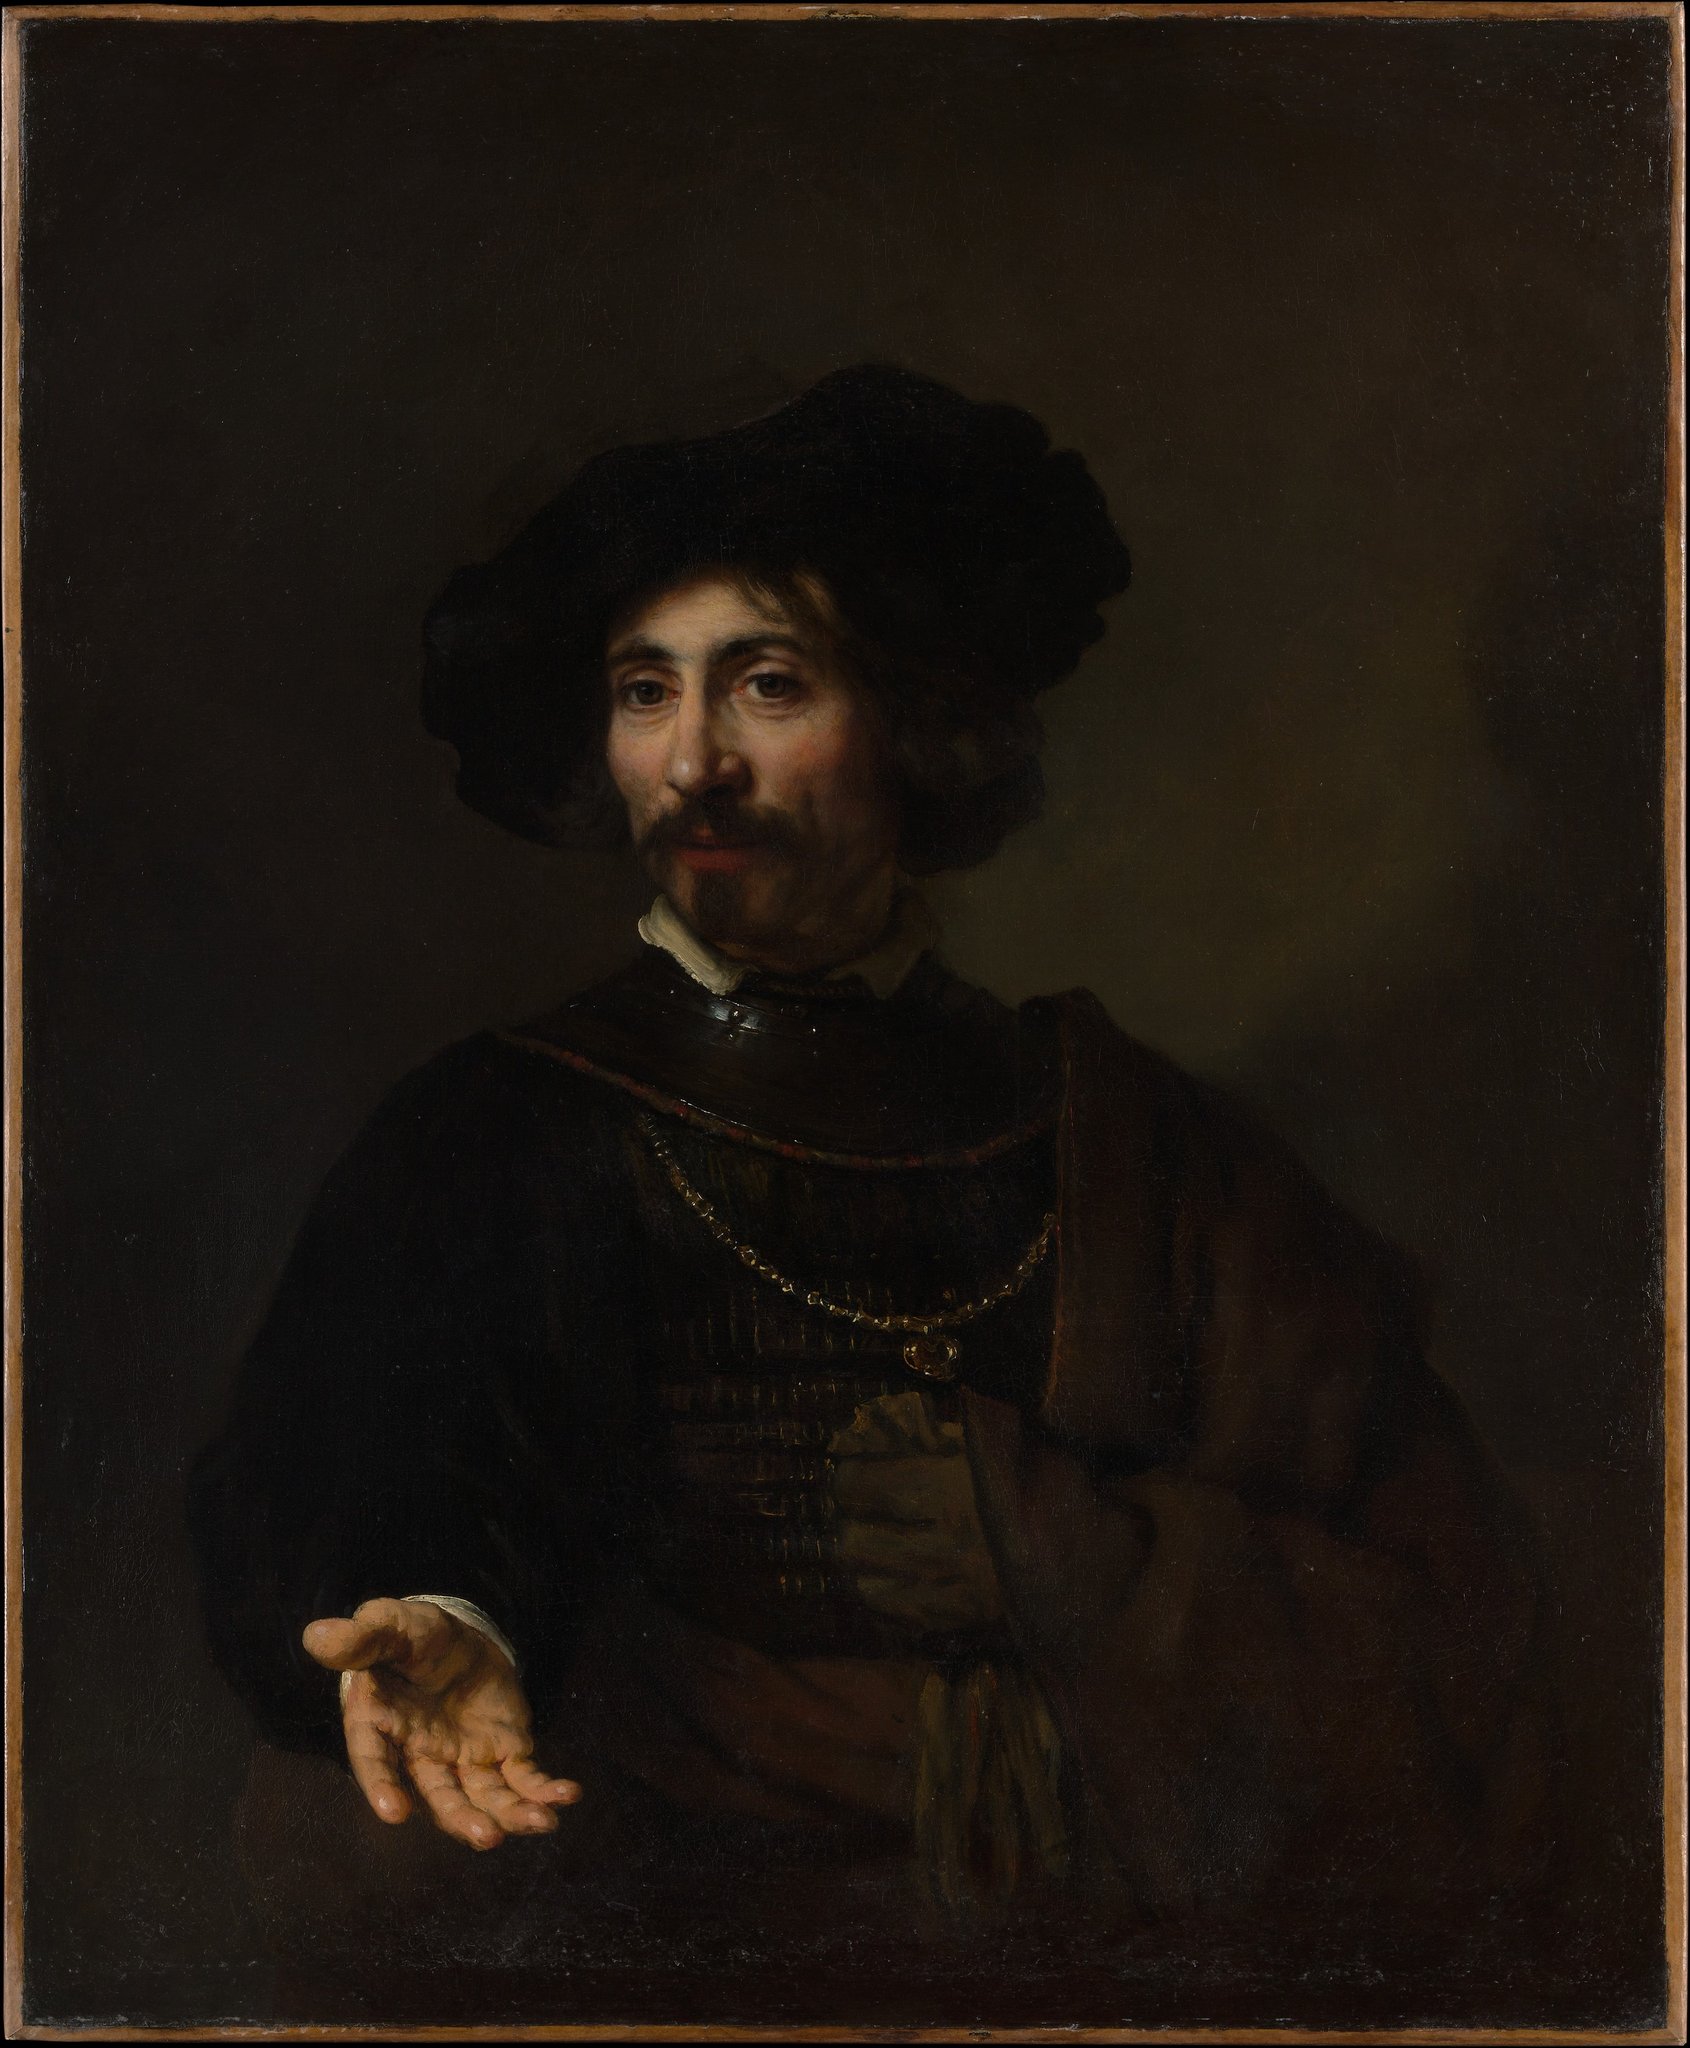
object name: painting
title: Man with a Steel Gorget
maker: rembrandt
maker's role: artist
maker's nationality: dutch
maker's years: 1606-1669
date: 1625-1674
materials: canvas, oil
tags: men,portraits